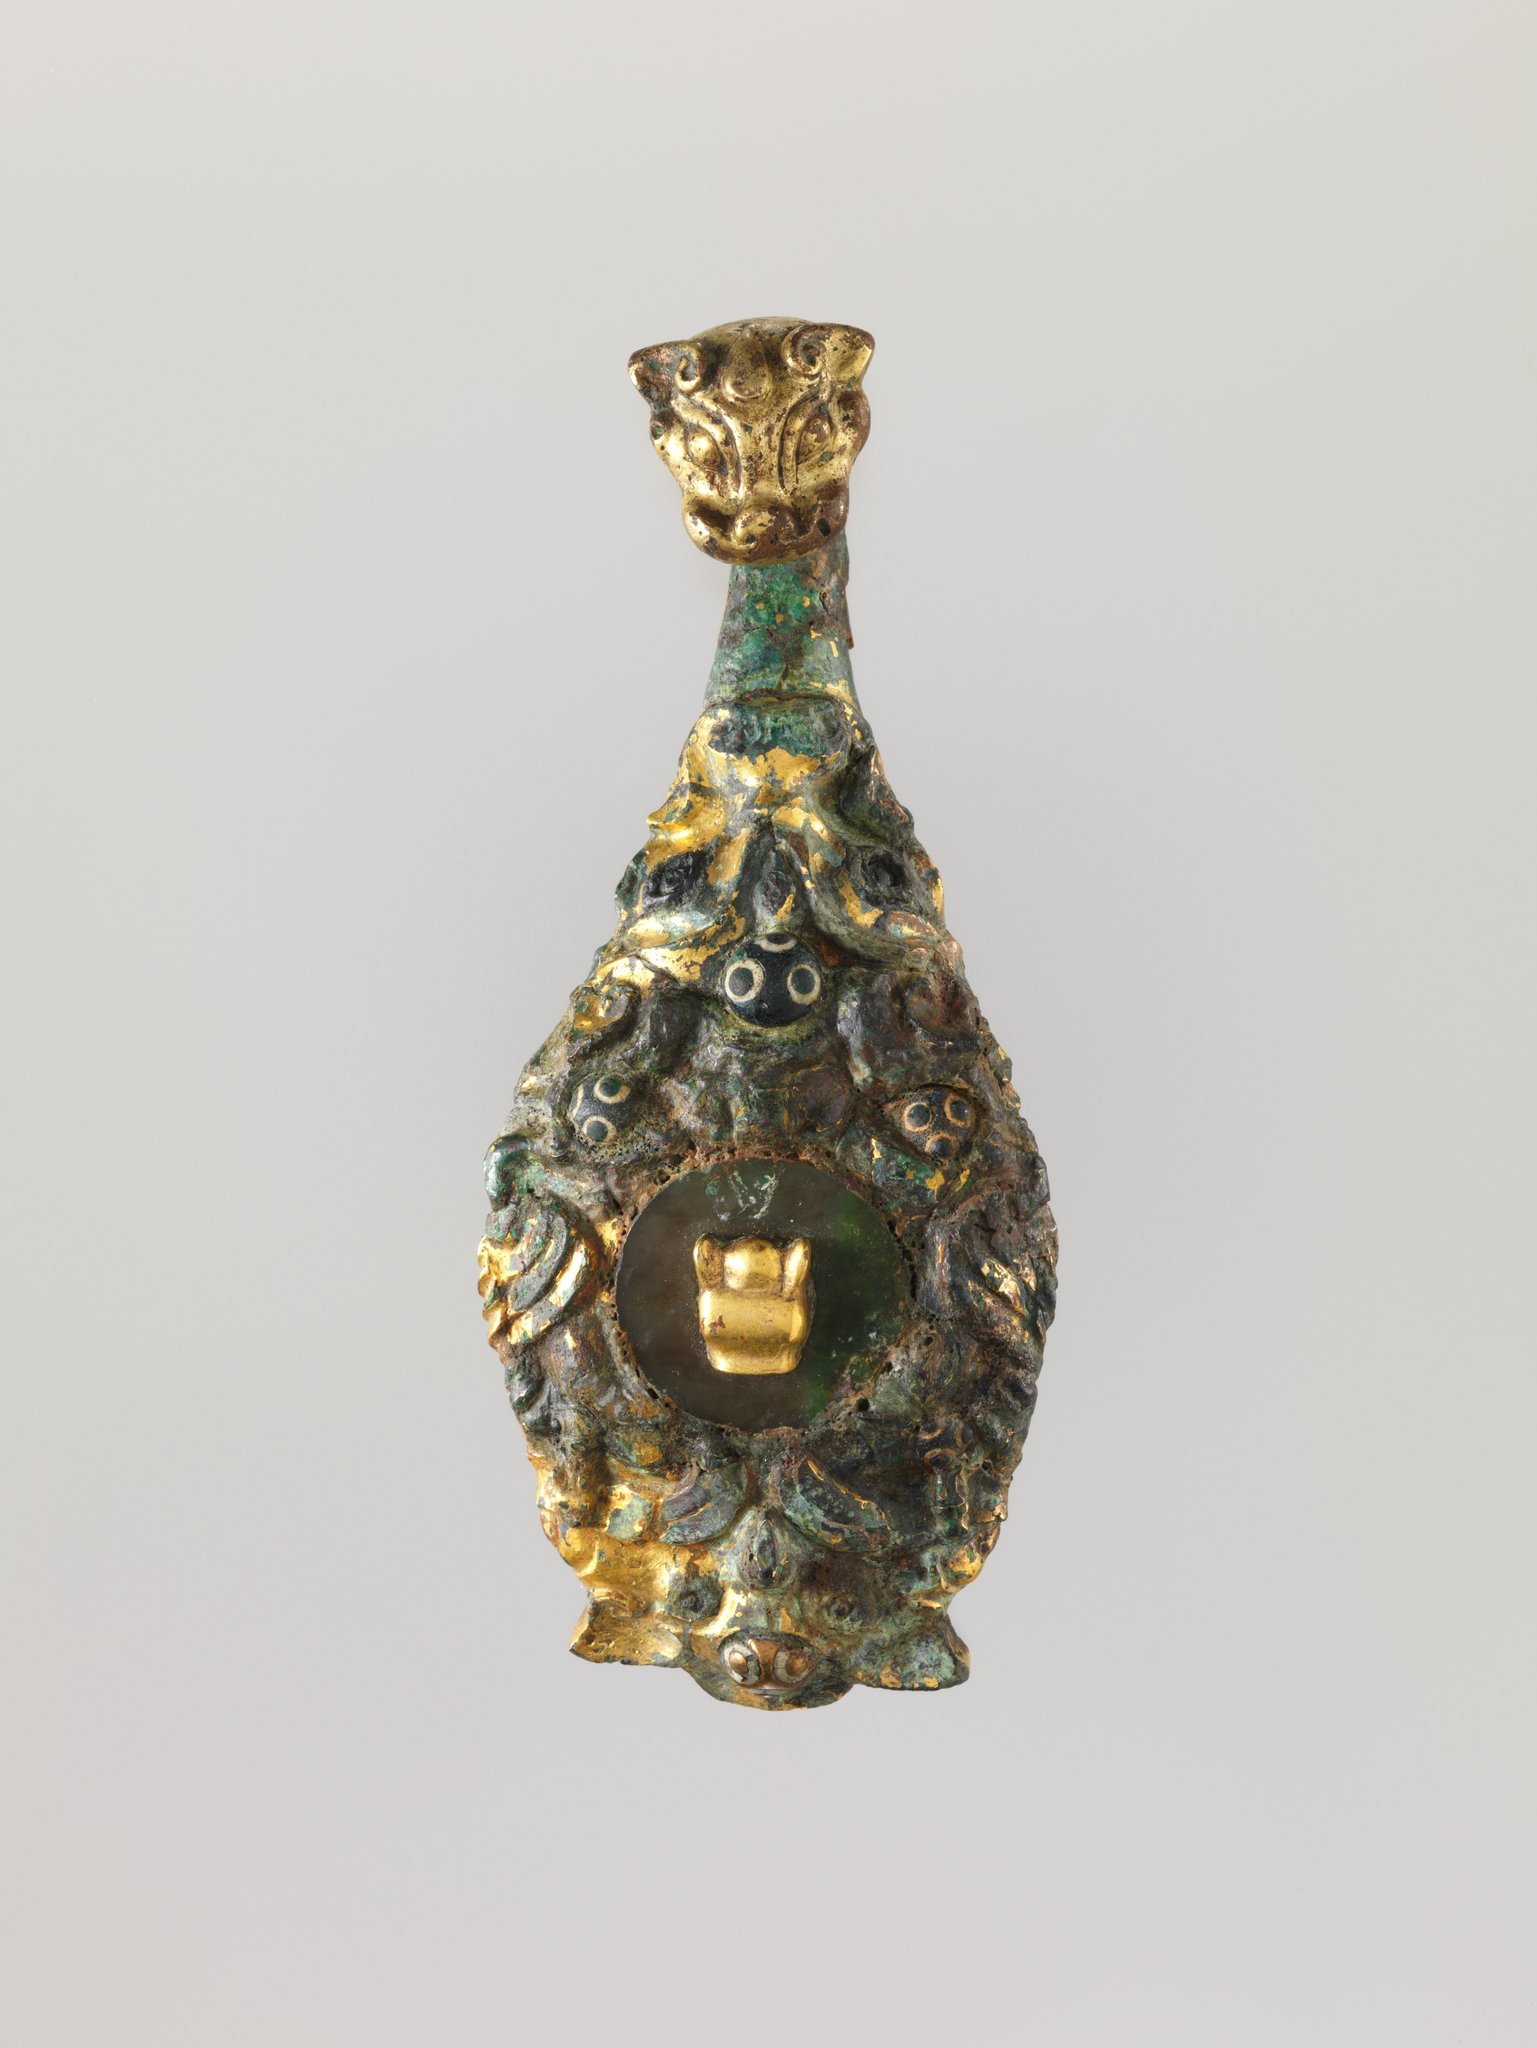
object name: buckle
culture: chinese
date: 206 BCE-220 CE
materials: gilt bronze, glass, jade